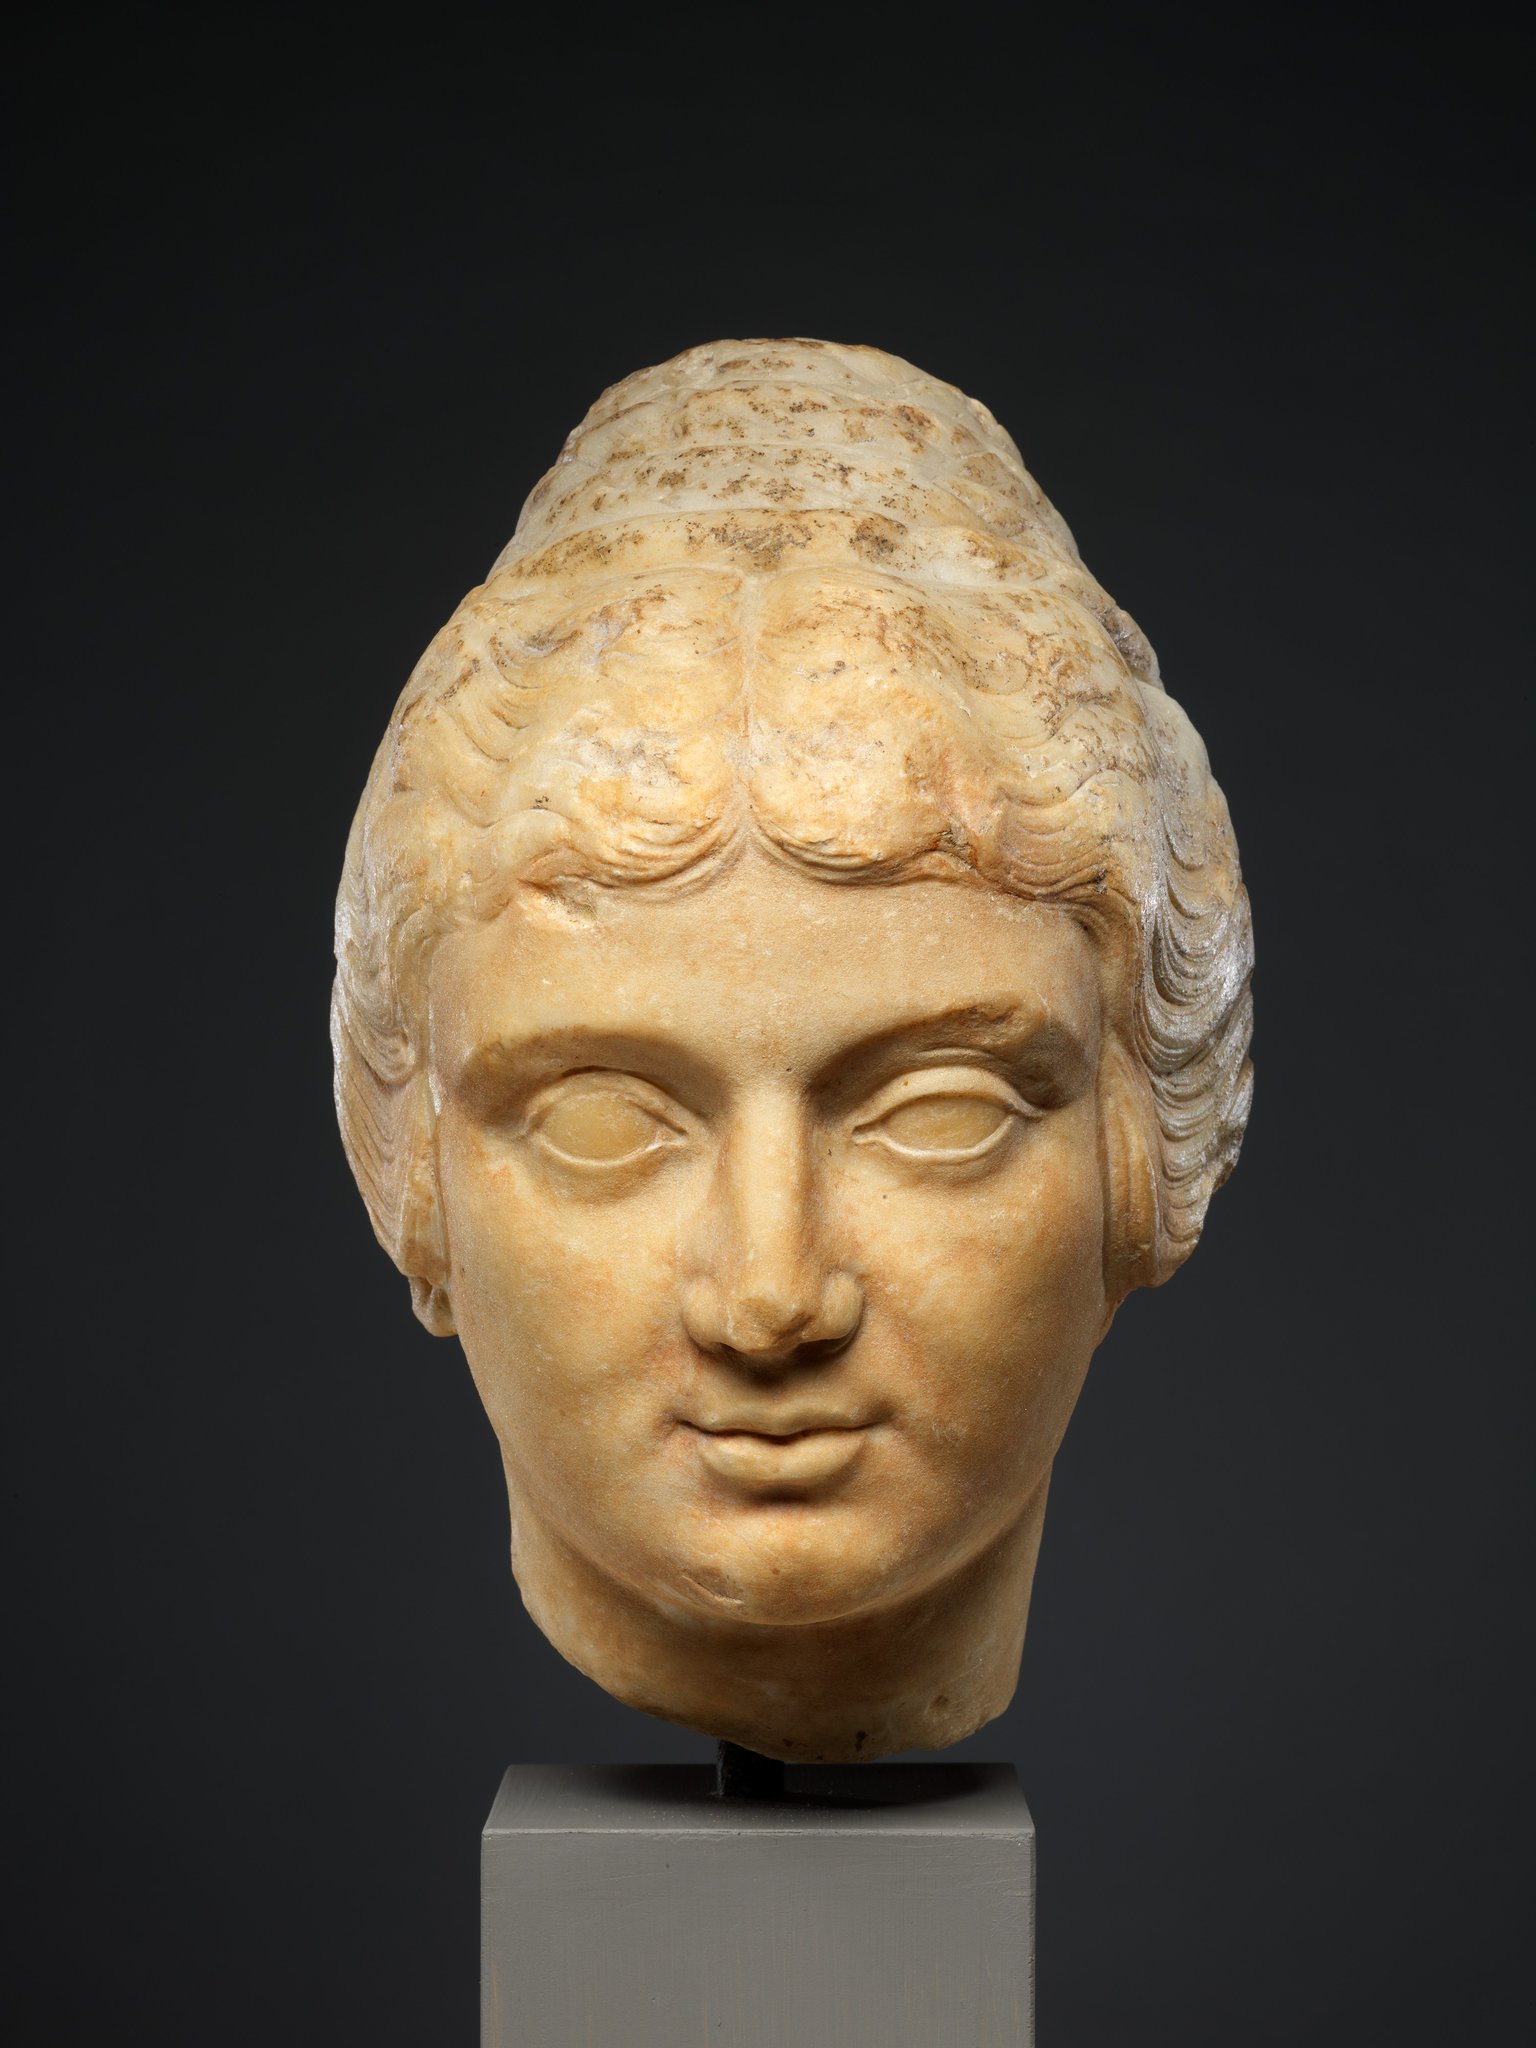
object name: head of a woman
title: Marble head of a woman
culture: roman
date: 150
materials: marble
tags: heads,women